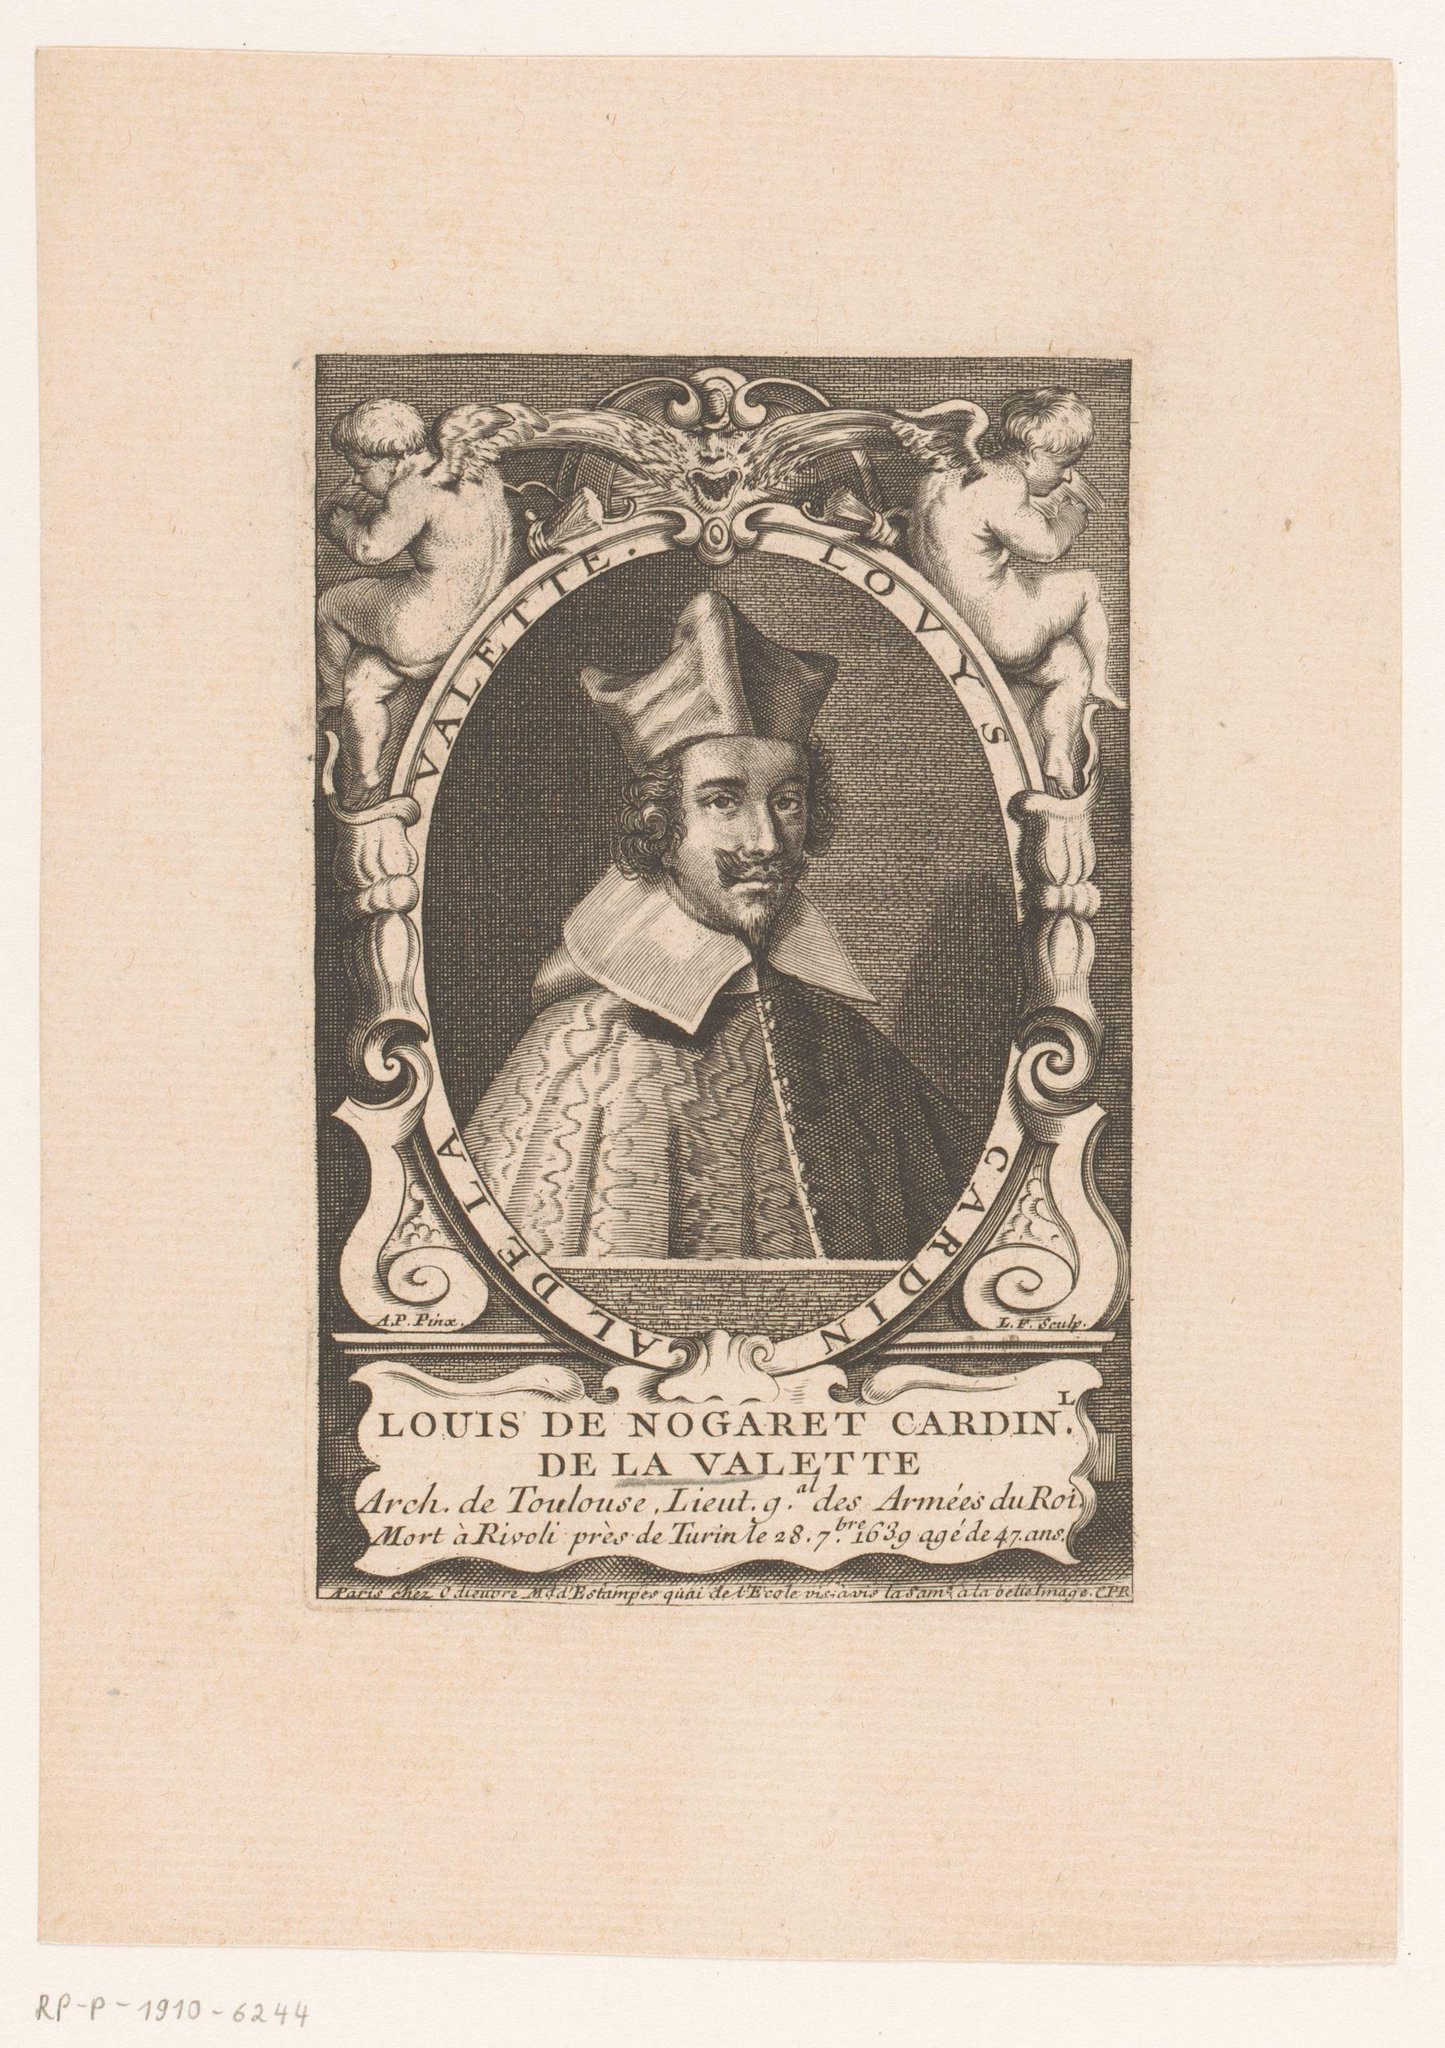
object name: print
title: Portret van Louis de Nogaret de La Valette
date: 1697-1756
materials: paper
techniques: engraving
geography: paris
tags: louis de nogaret de la valette, archbishop, bishop, etc. (roman catholic), historical persons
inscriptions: collector's mark: Lugt 2228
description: Prent uit: Dreux du Radier, Jean-François. L'Europe illustré, contenant l'histoire abregée des souverains, des princes, des prélats, des ministres, (...) en Europe: dans le XVe. siècle compris, jusqu'à présent. Parijs: Michel Odieuvre en Jean-Luc Nyon.